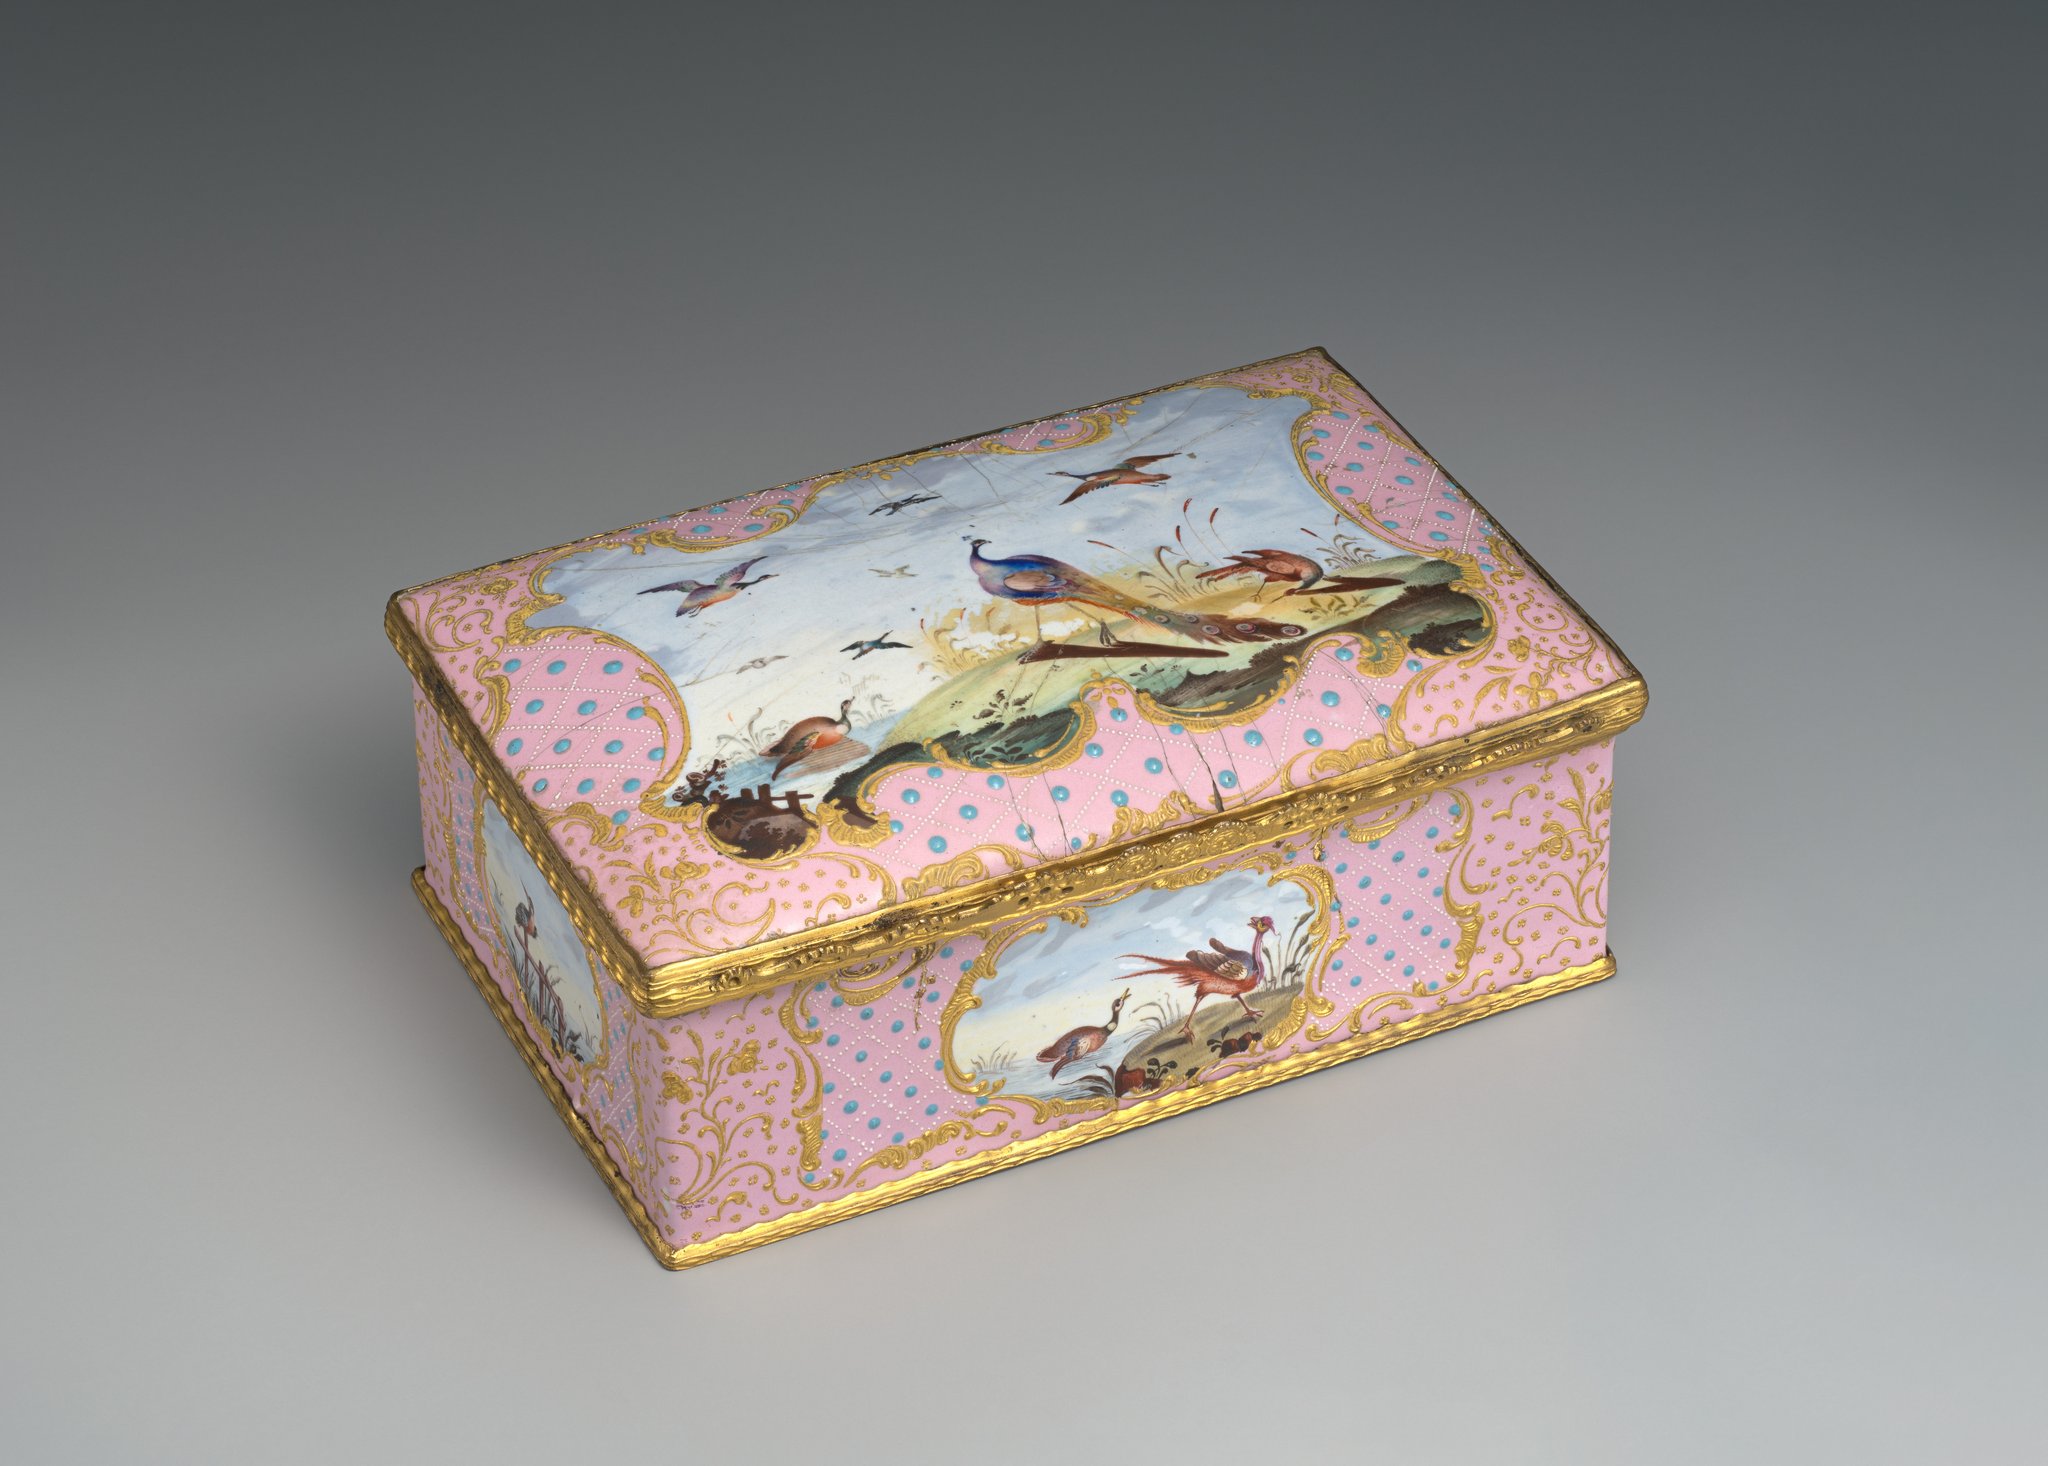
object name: box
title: Toilet box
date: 1765-1770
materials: copper, enamel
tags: birds,peacocks